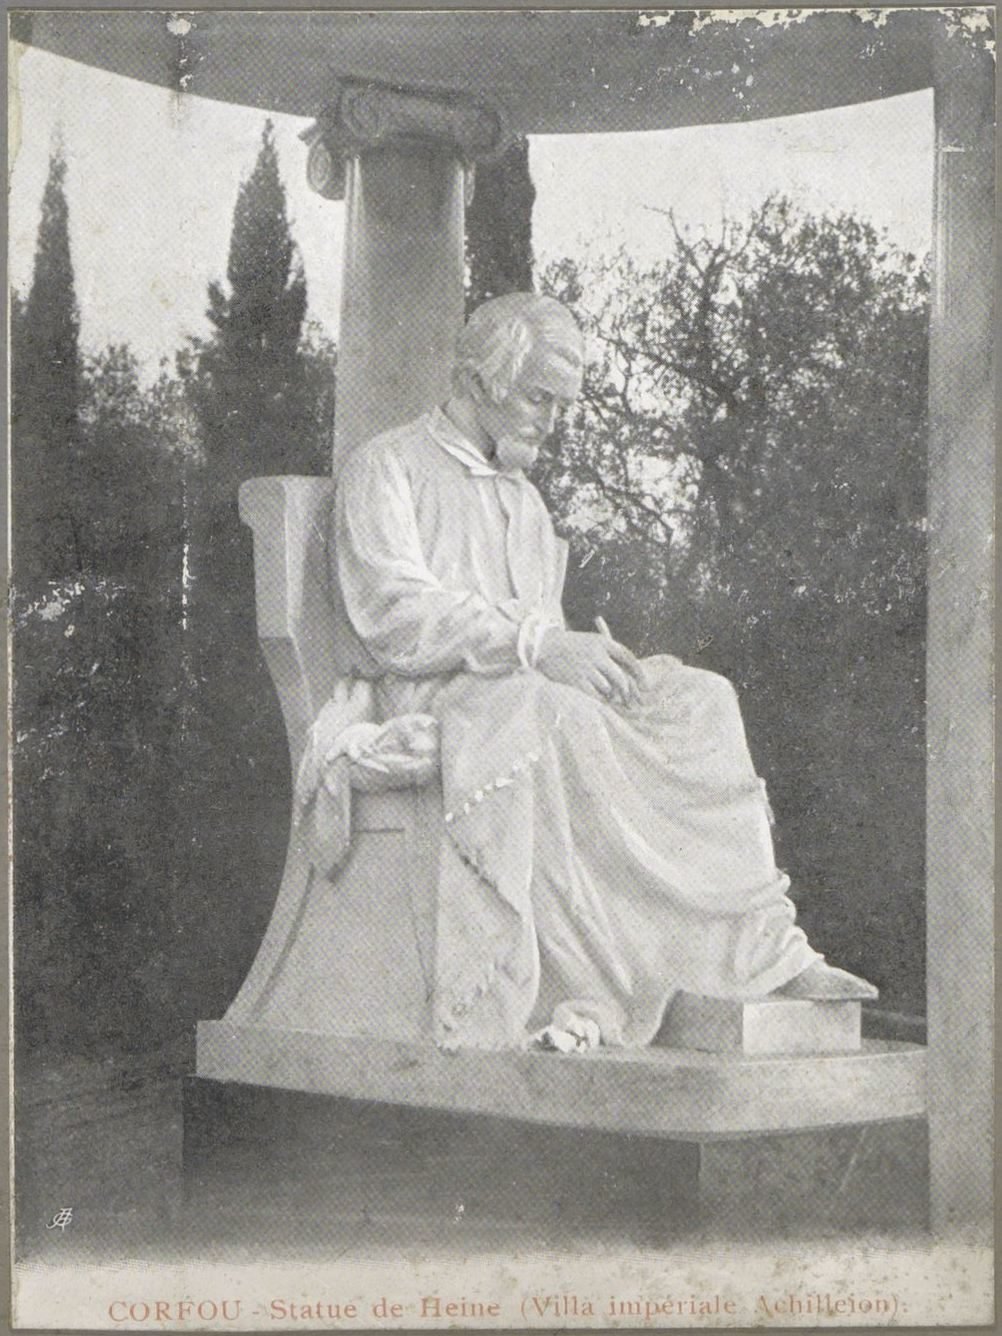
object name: album leaf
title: Beeld van Heinrich Heine in het Achilleion op Corfu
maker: adolphe giraudon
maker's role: publisher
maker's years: 1849-1929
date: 1895-1905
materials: paper, photographic support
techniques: autotype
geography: corfu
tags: monument, statue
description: Onderdeel van Reisalbum met foto's van bezienswaardigheden in Griekenland en Egypte.